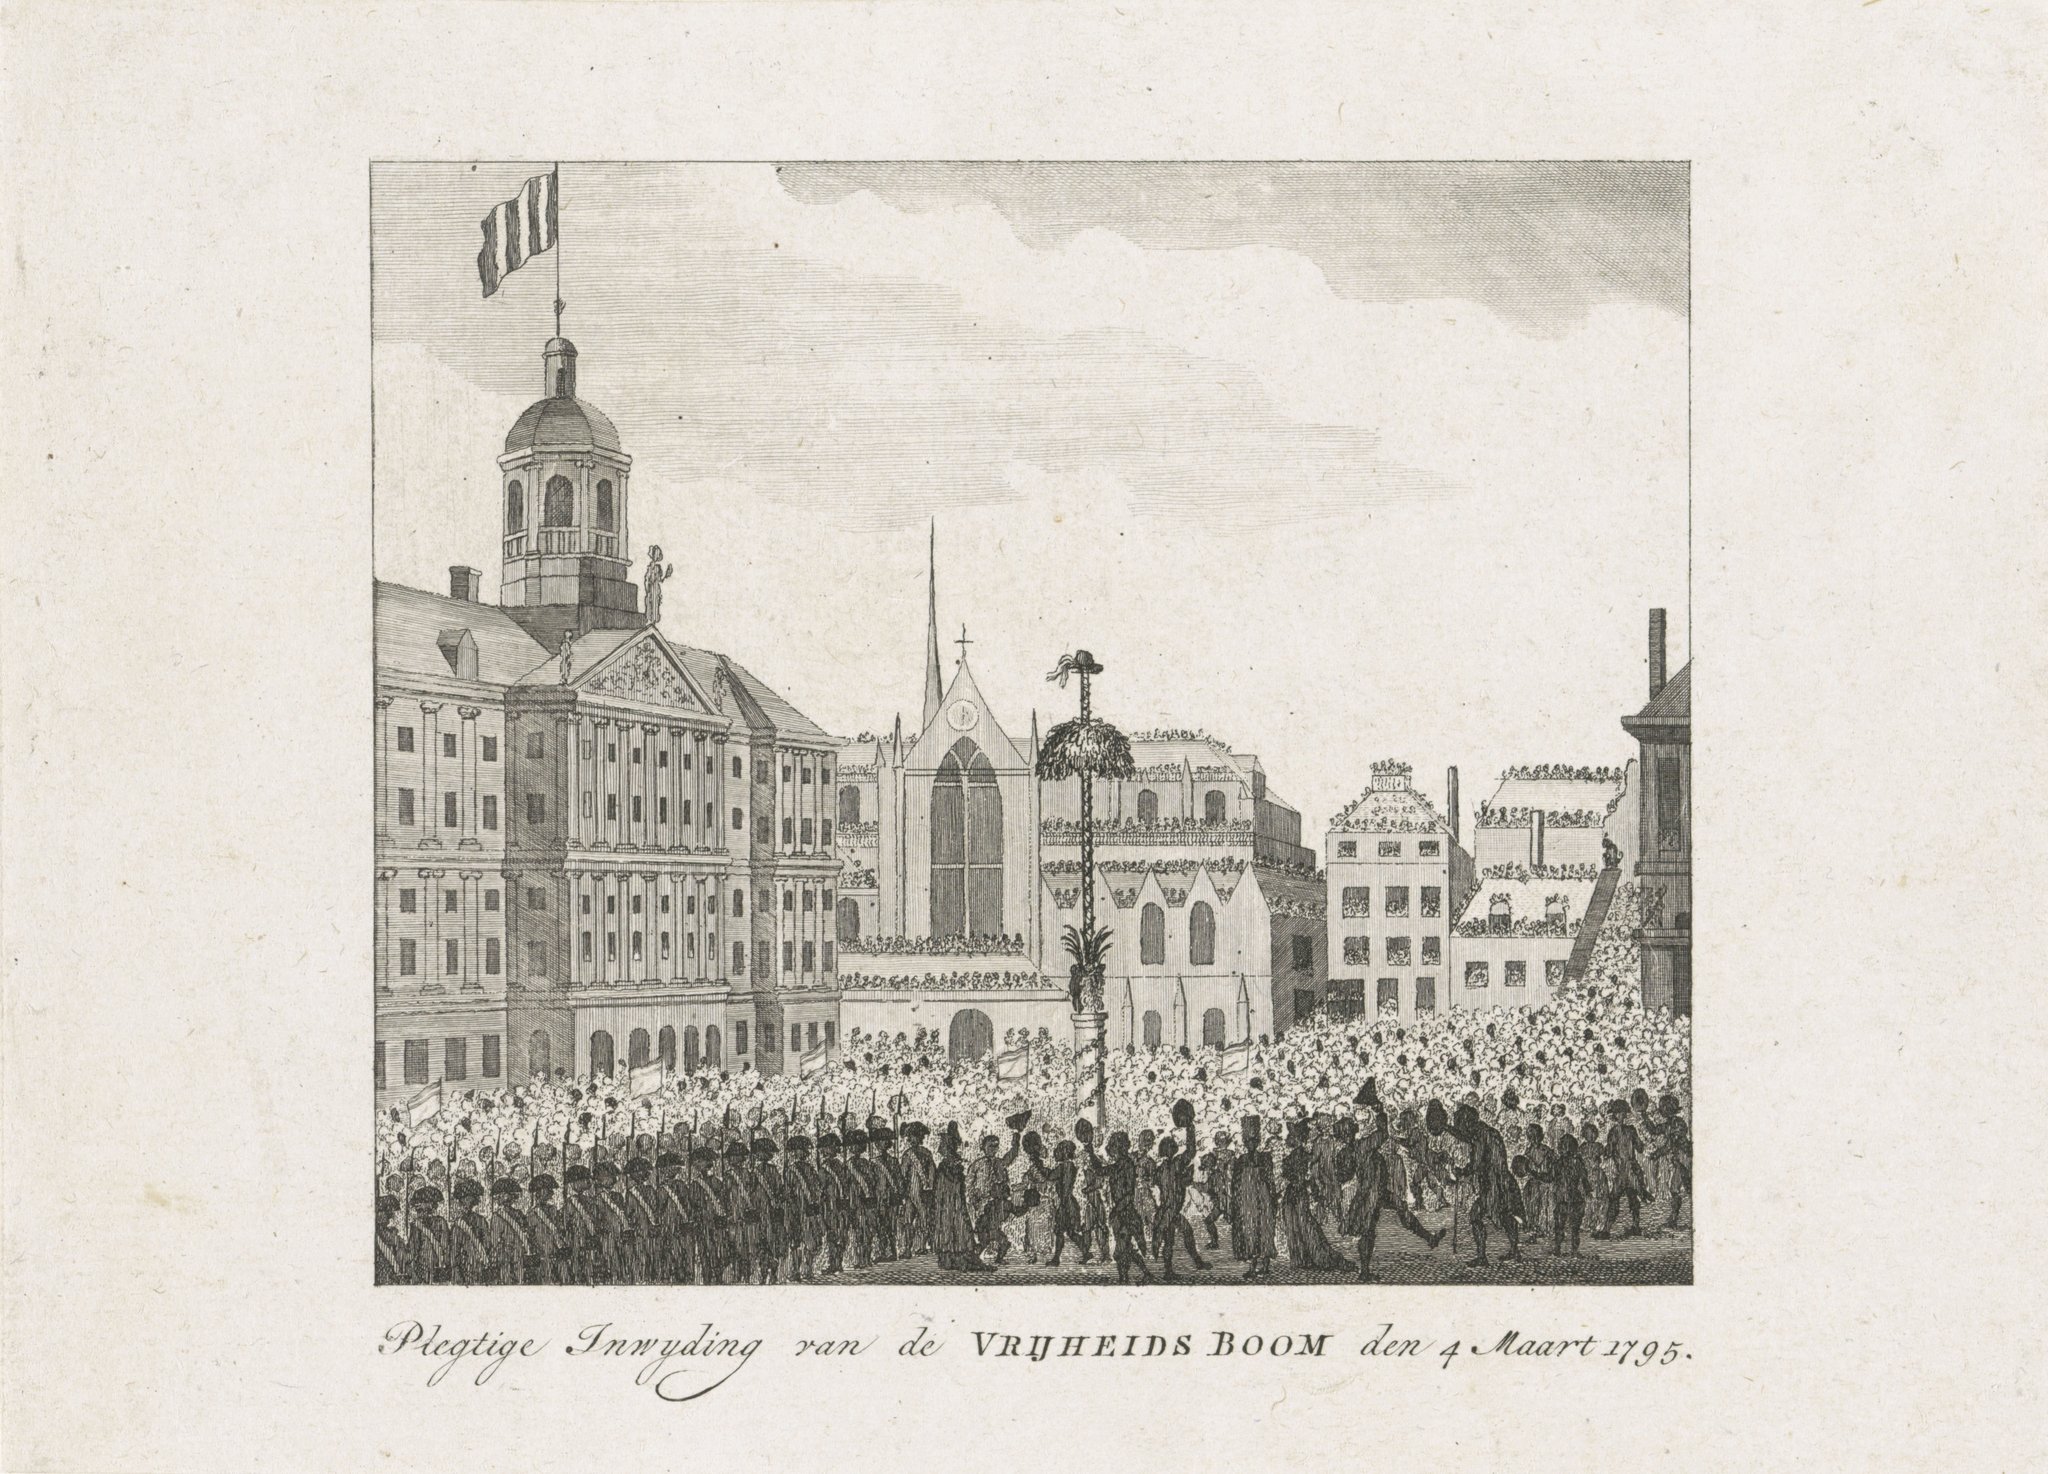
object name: print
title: Plegtige Inwyding van de Vrijheids Boom den 4 Maart 1795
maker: Anonymous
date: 1795-1799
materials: paper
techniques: etching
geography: netherlands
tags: dancing around the tree of liberty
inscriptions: collector's mark: Lugt 2228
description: Feest der Vrijheid, gevierd bij de inwijding van de vrijheidsboom op de Dam te Amsterdam, 4 maart 1795. Gezicht op de Dam met een grote menigte dansend om de vrijheidsboom.